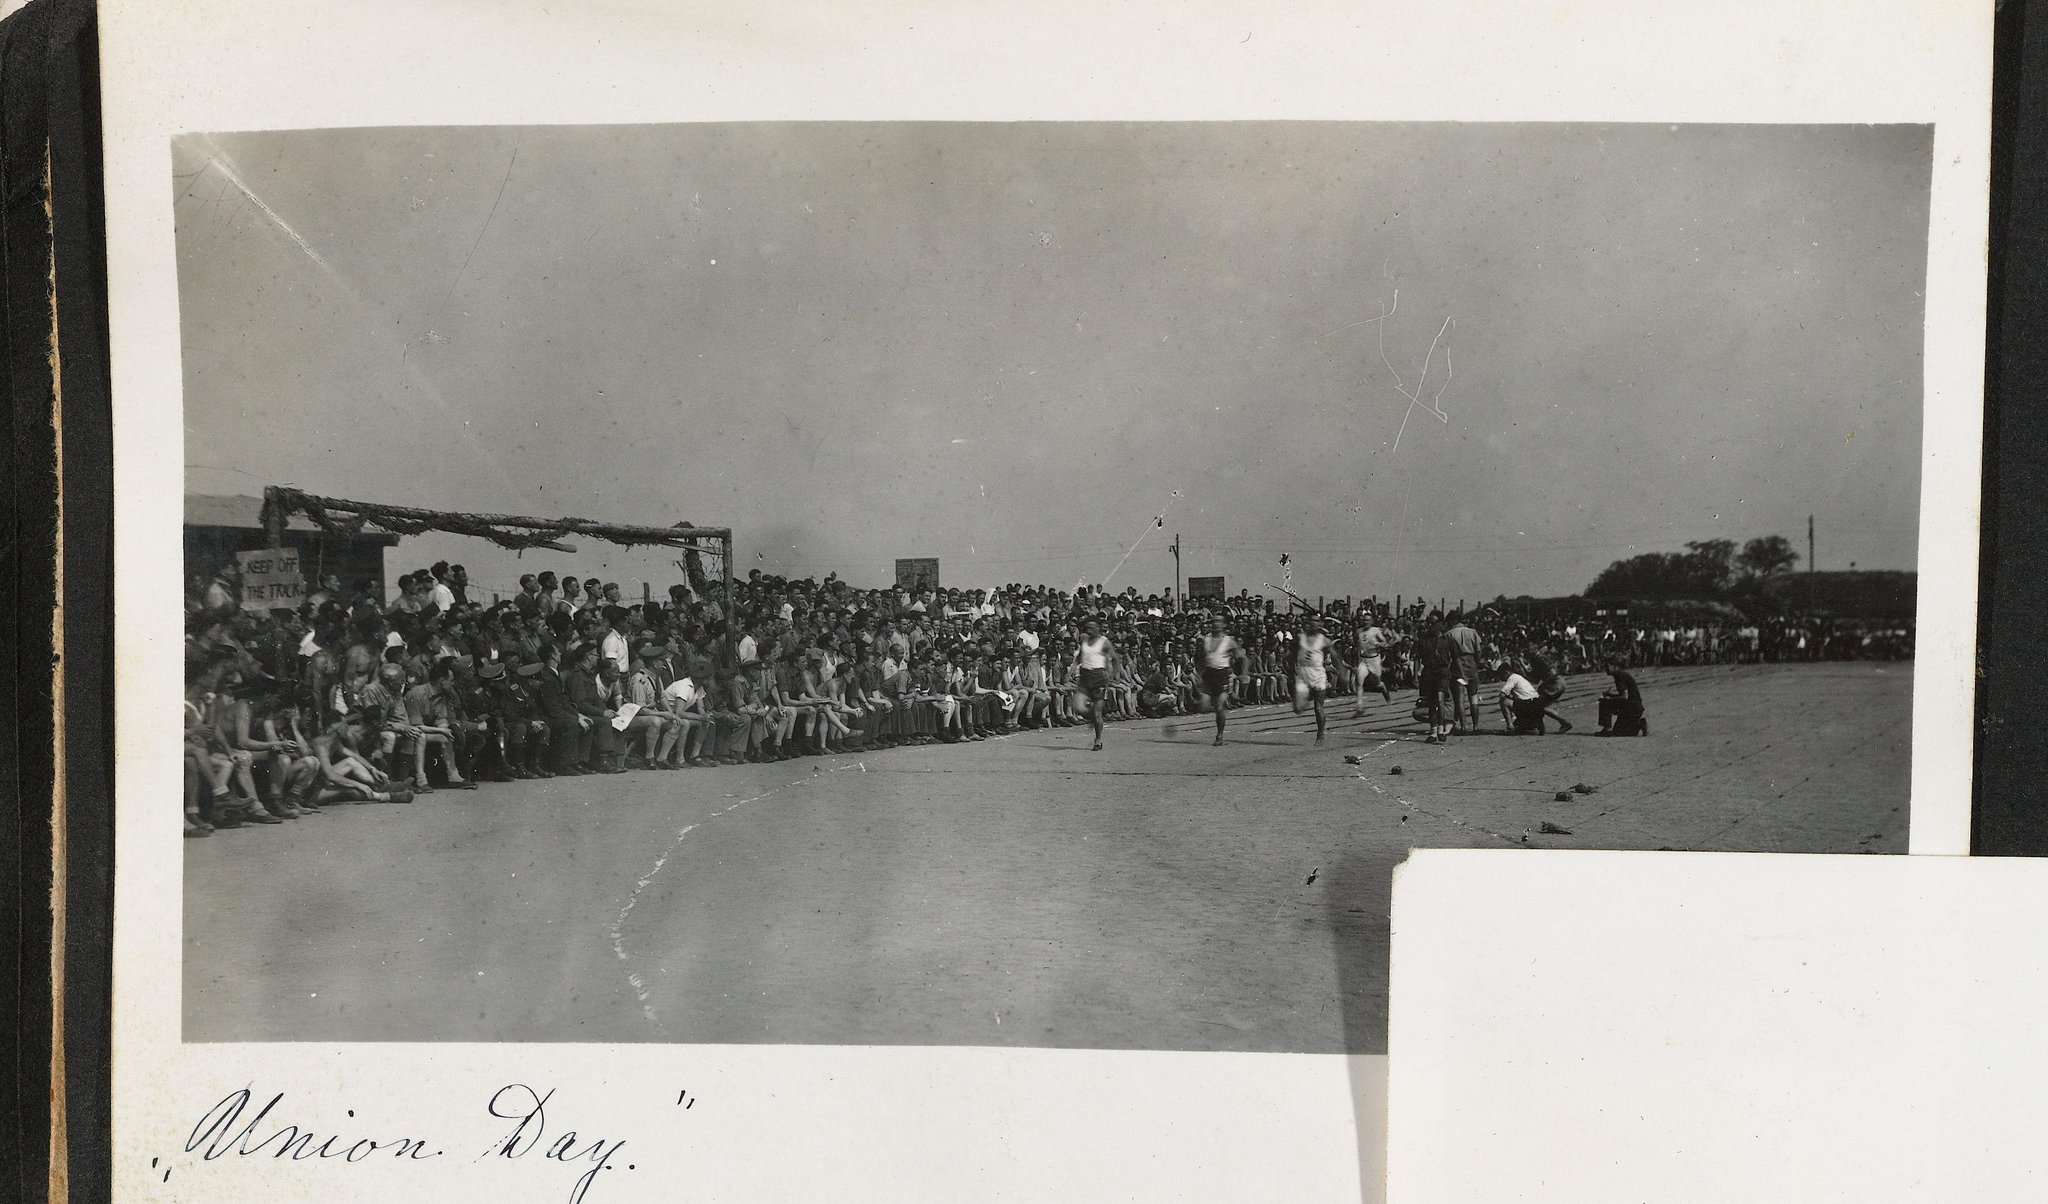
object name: photograph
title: Union Day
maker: dick w.b. van maarseveen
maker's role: fotograaf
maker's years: 1905-1990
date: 1943-1945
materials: cardboard, photographic support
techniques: gelatin silver print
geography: muhlberg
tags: the hague, dick w.b. van maarseveen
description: Albumblad met twee foto’s: de viering van Union Day (31 mei) met een loop- en voetbalwedstrijd door de Zuid-Afrikaanse gevangenen. Onderdeel van een fotoalbum met foto's door Dick van Maarseveen van het krijgsgevangenenkamp Stalag IV B in Mühlberg in de periode 1943-1945.